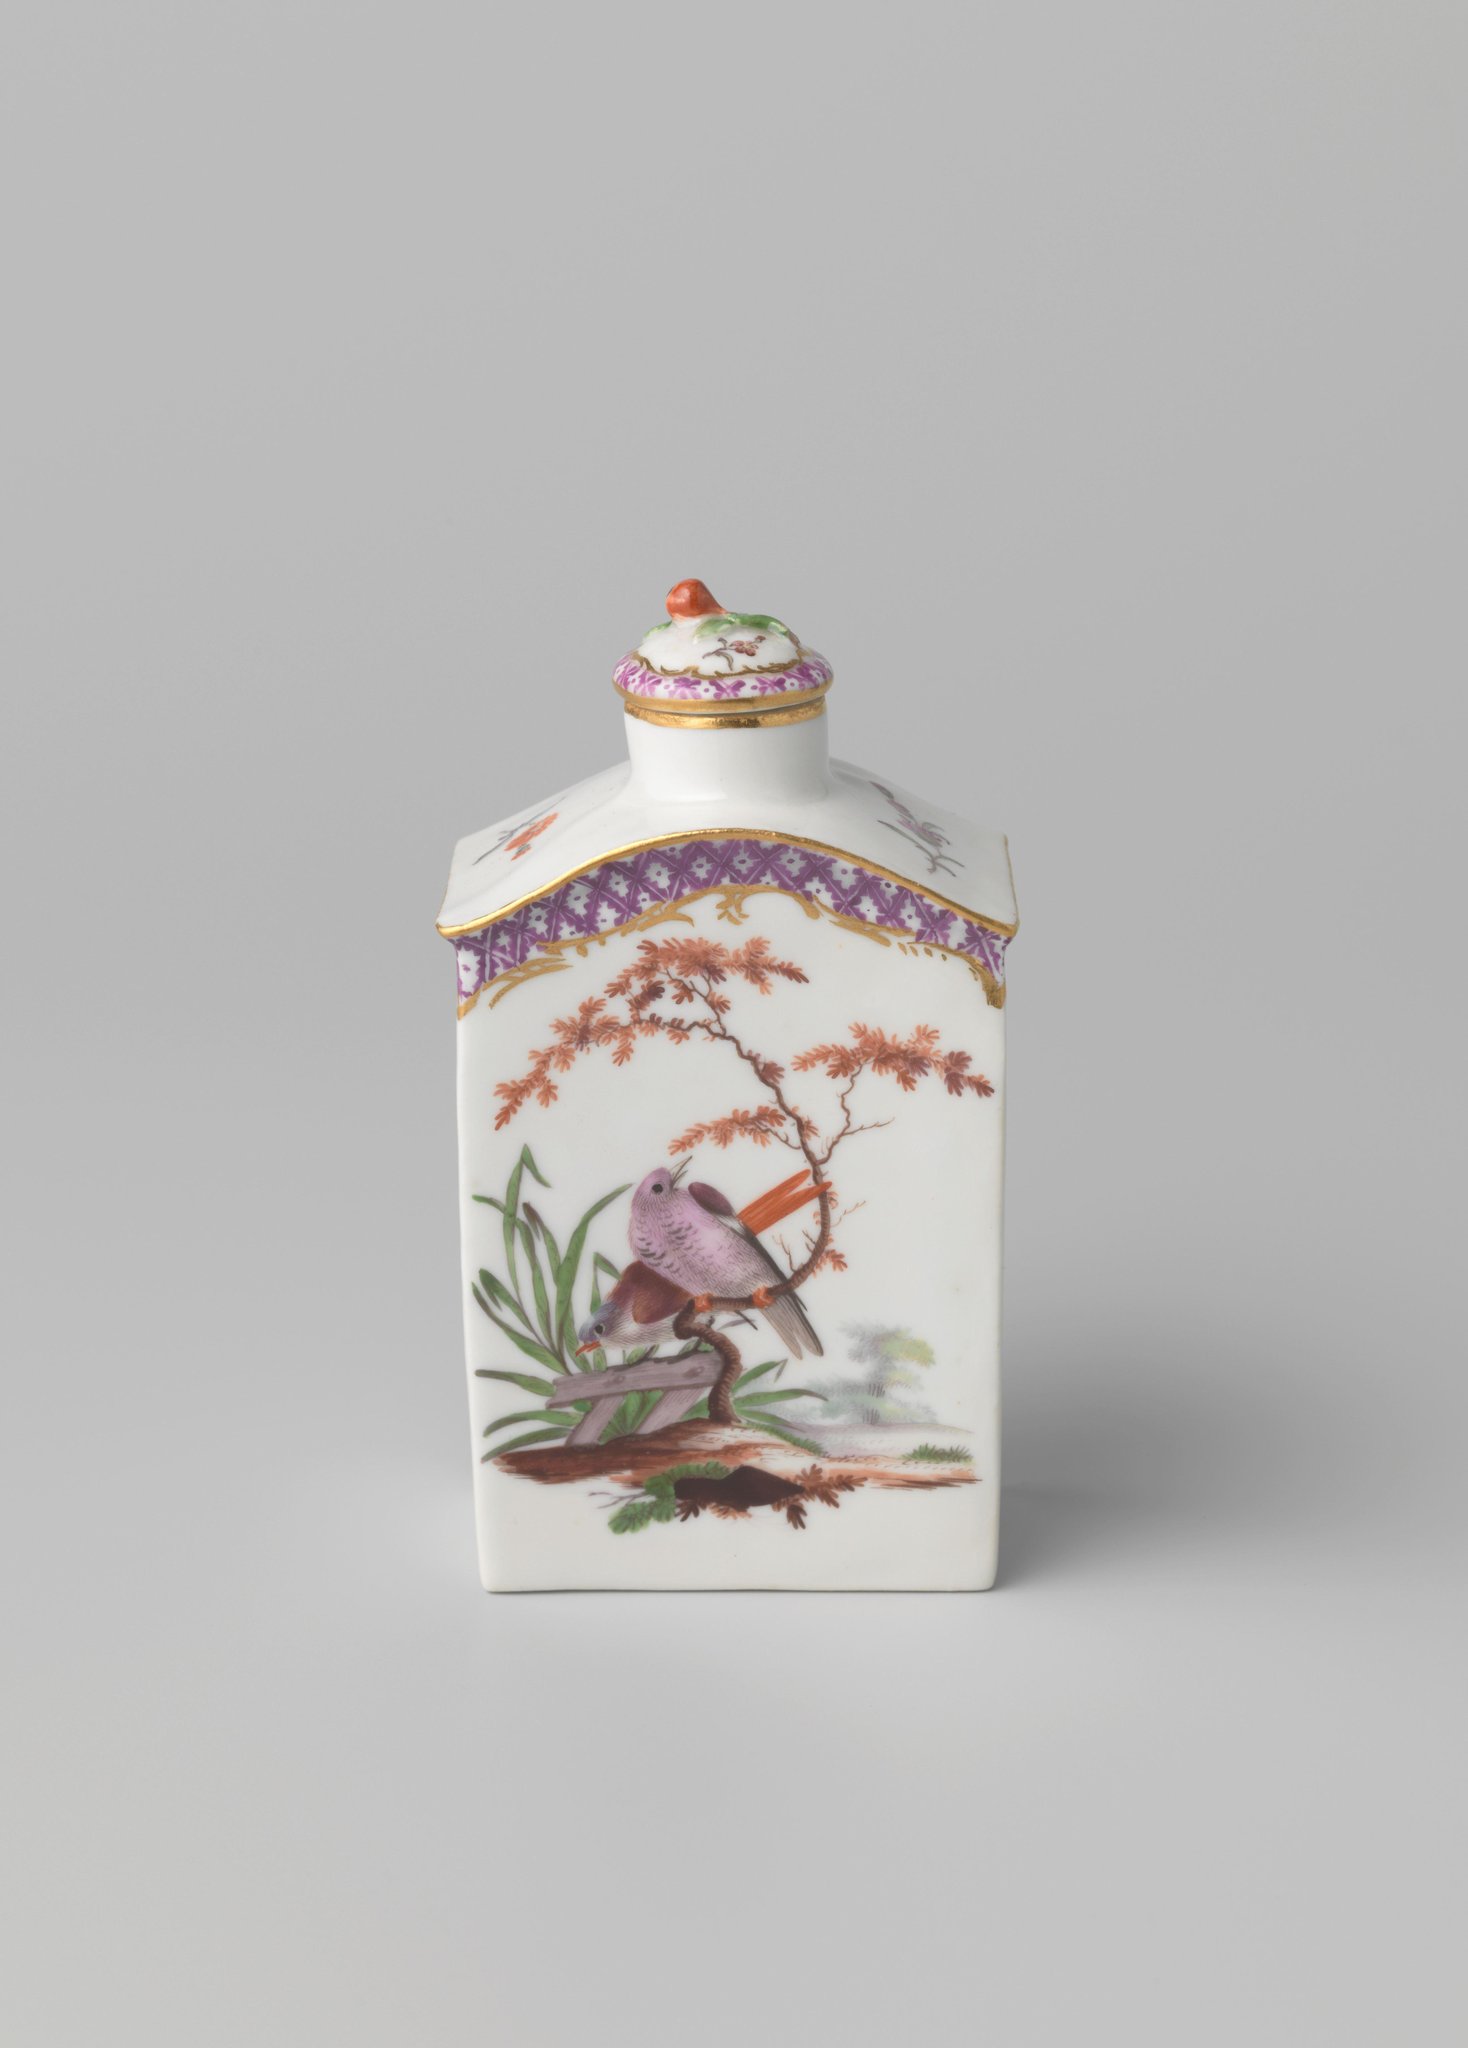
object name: tea caddy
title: Tea caddy with birds in a landscape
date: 1765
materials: glaze, gold, paint, porcelain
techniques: firing, forming, gilding, turning, vitrification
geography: ansbach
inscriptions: mark: ‘A’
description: Theebus van porselein met met een rechthoekig lichaam, korte, ronde nek en schuin aflopende, iets uitstekende schouder. Beschilderd op het glazuur in emailkleuren en goud. Op de brede vakken van de buik twee vogels in een landschap. De smalle vakken en de schouder met strooibloemen. Op de rand vlak onder de schouder een band met servetwerk, waaronder gouden ranken. Gouden lijn op de nek. De deksel met strooibloemen heeft dezelfde band met servetwerk; dekselknop in de vorm van een fruittak (peer). Gemerkt op de onderzijde met de A.